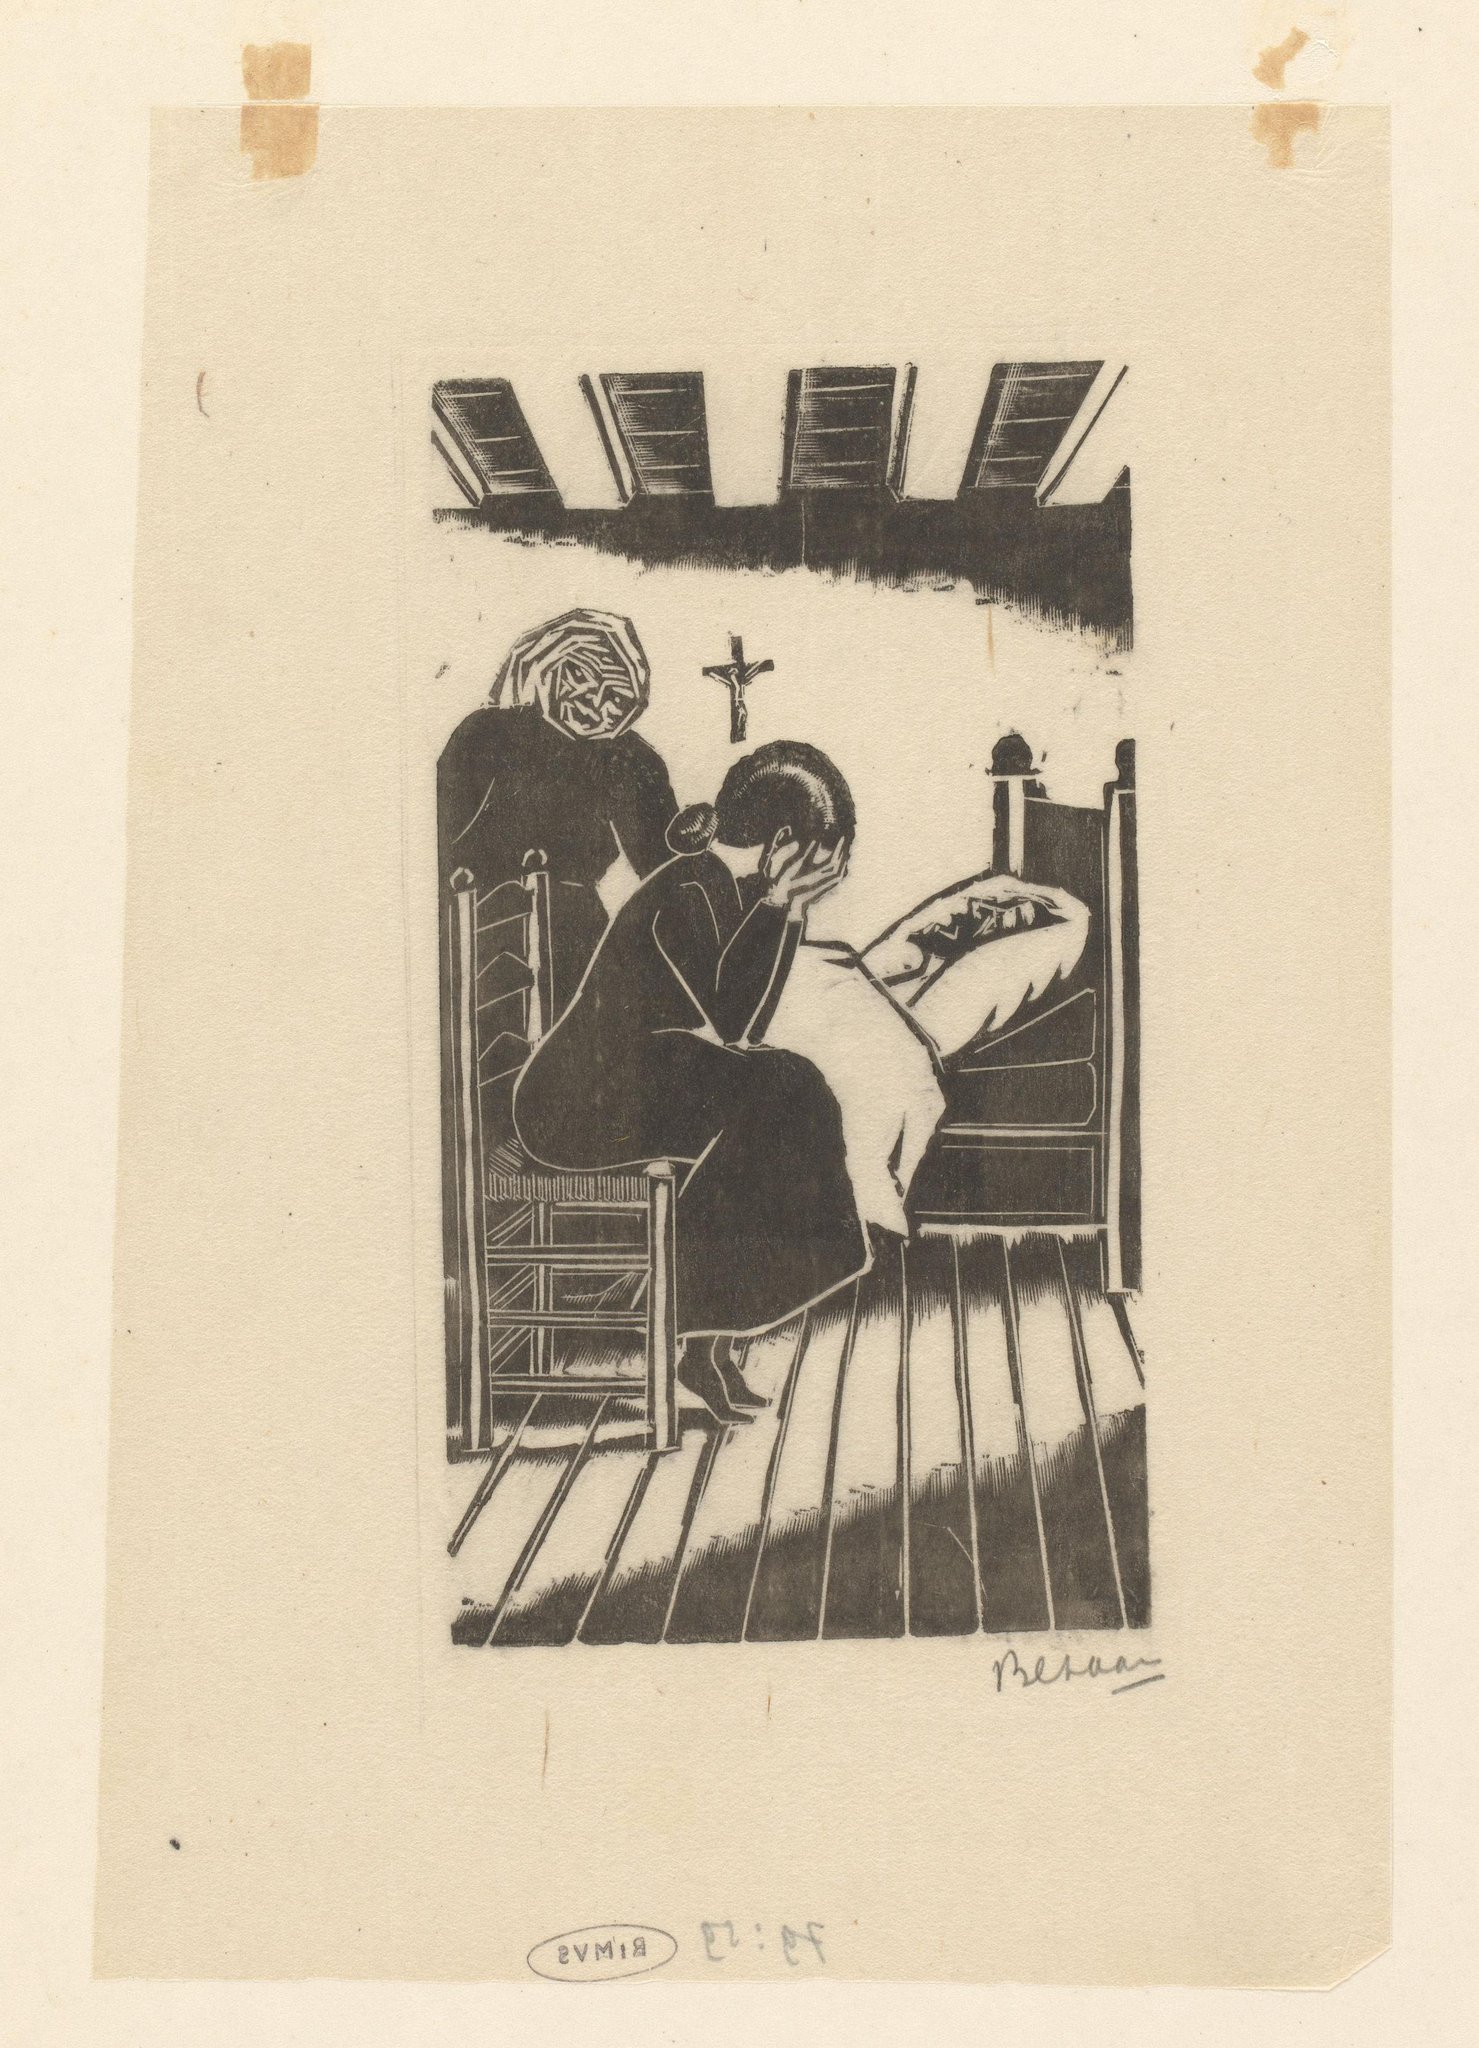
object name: book illustration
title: Zij zakte snikkend, met haar handen vóór de oogen, op een stoel en bleef er zitten schreien, eindeloos, eindeloos lang...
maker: jo bezaan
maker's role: draughtsman, print maker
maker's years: 1894-1952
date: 1942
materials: paper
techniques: woodcut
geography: amsterdam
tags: deathbed, mourning the dead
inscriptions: collector's mark: Lugt 2228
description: Prent gebruikt voor: Buysse, Cyriel. Het leven van Rozeke van Dalen. Amsterdam: Contact-boekerij, 1942.